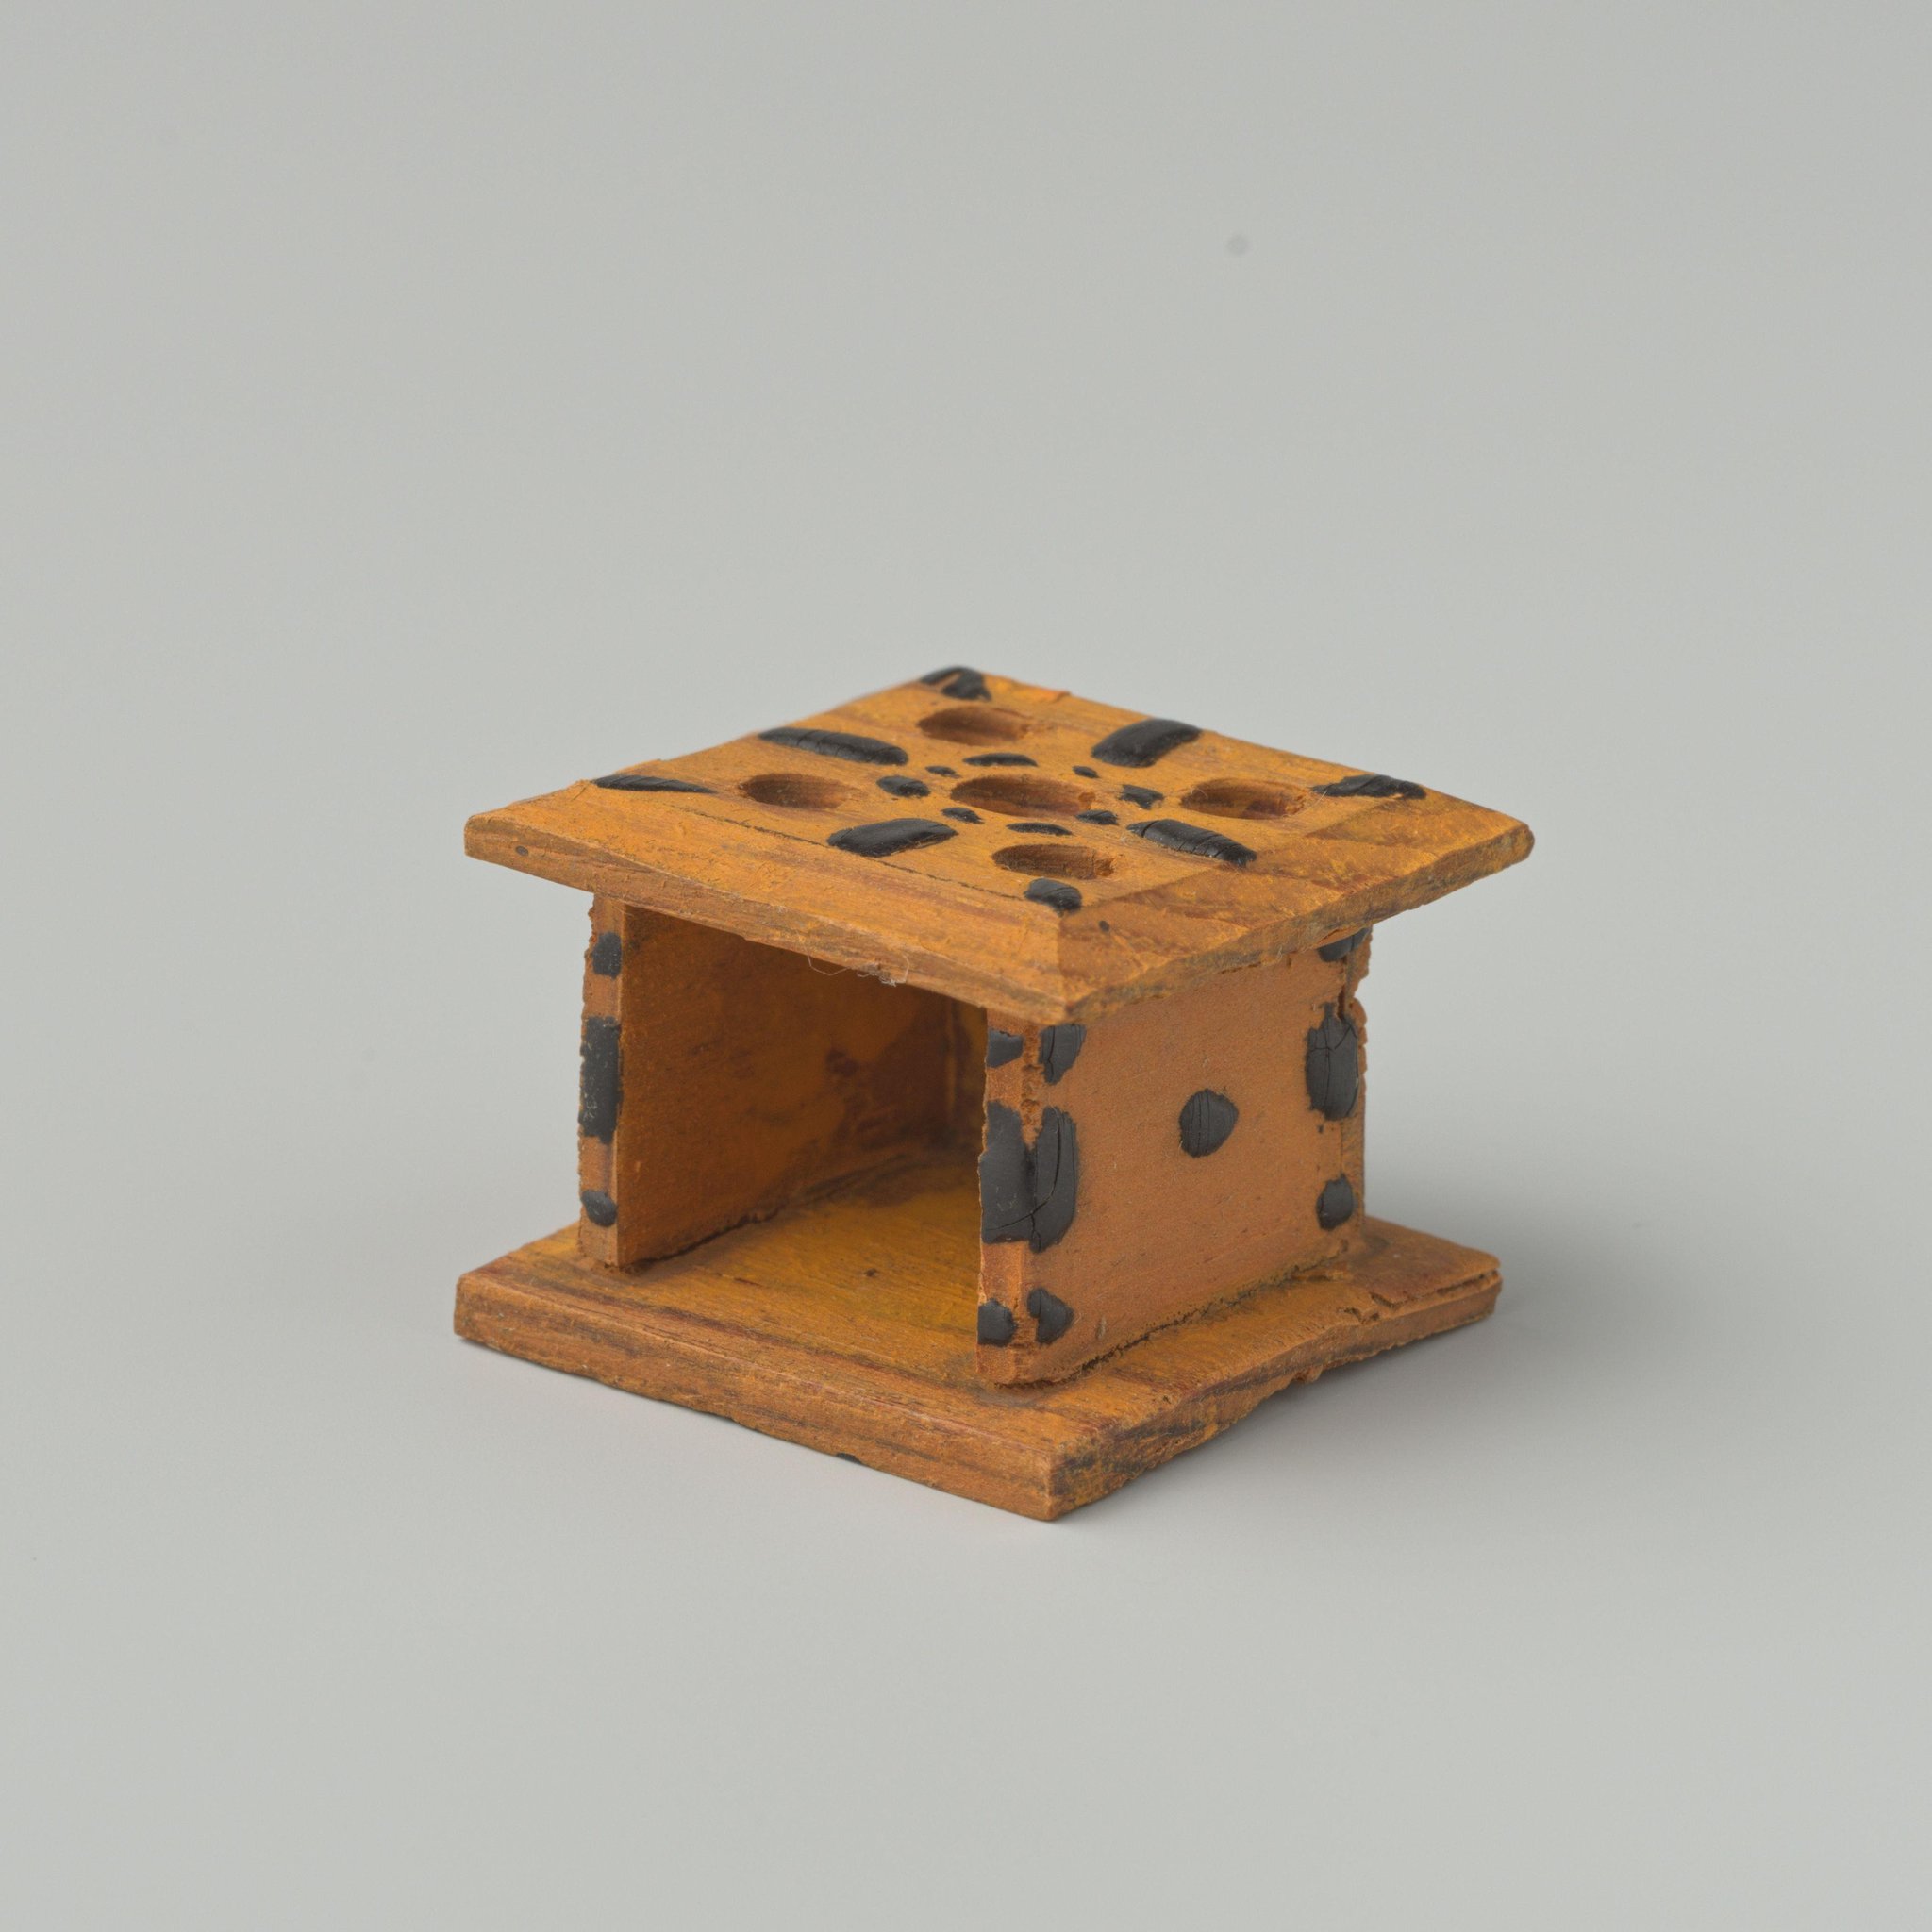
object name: voetstoof, stoof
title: Stoof, geel van kleur, versierd met zwarte stippen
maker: Anonymous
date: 1676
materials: without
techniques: without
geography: amsterdam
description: Stoof van without, vierkant van vorm. De geel gekleurde stoof is versierd met zwarte stippen. In de voetenplank zitten vijf gaten.